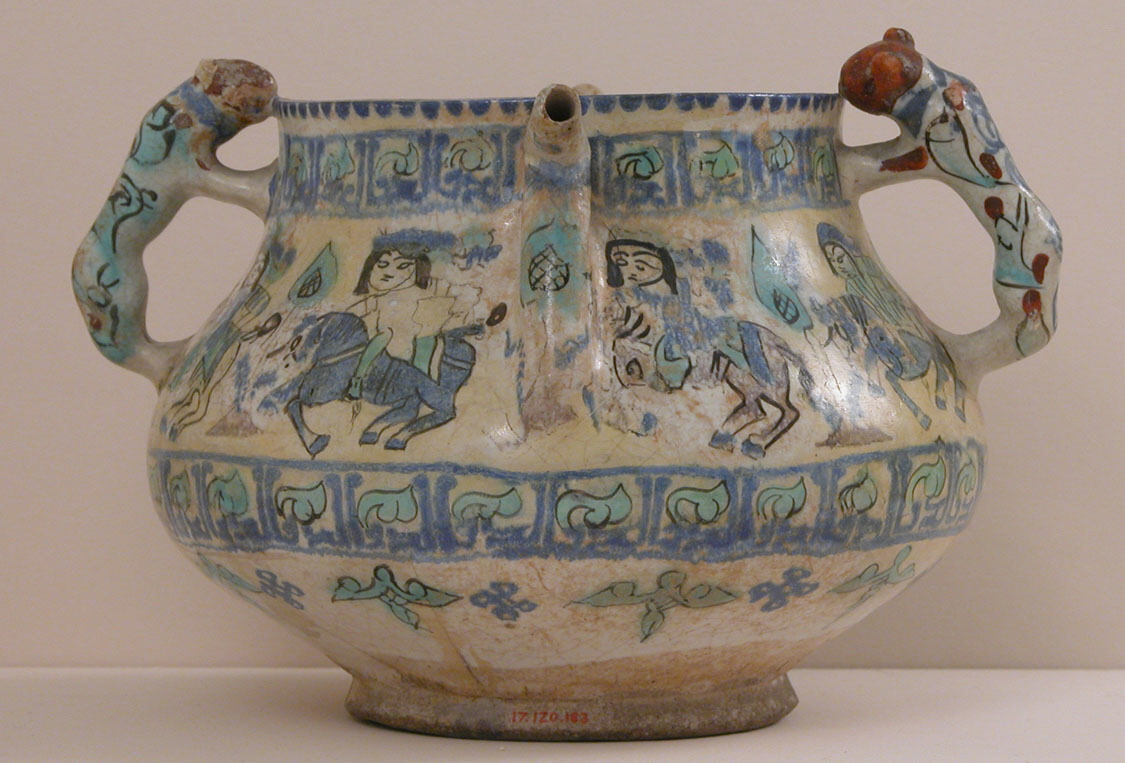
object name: jar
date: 1101-1300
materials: stonepaste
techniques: overglaze, painting, polychrome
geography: iran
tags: animals,horses